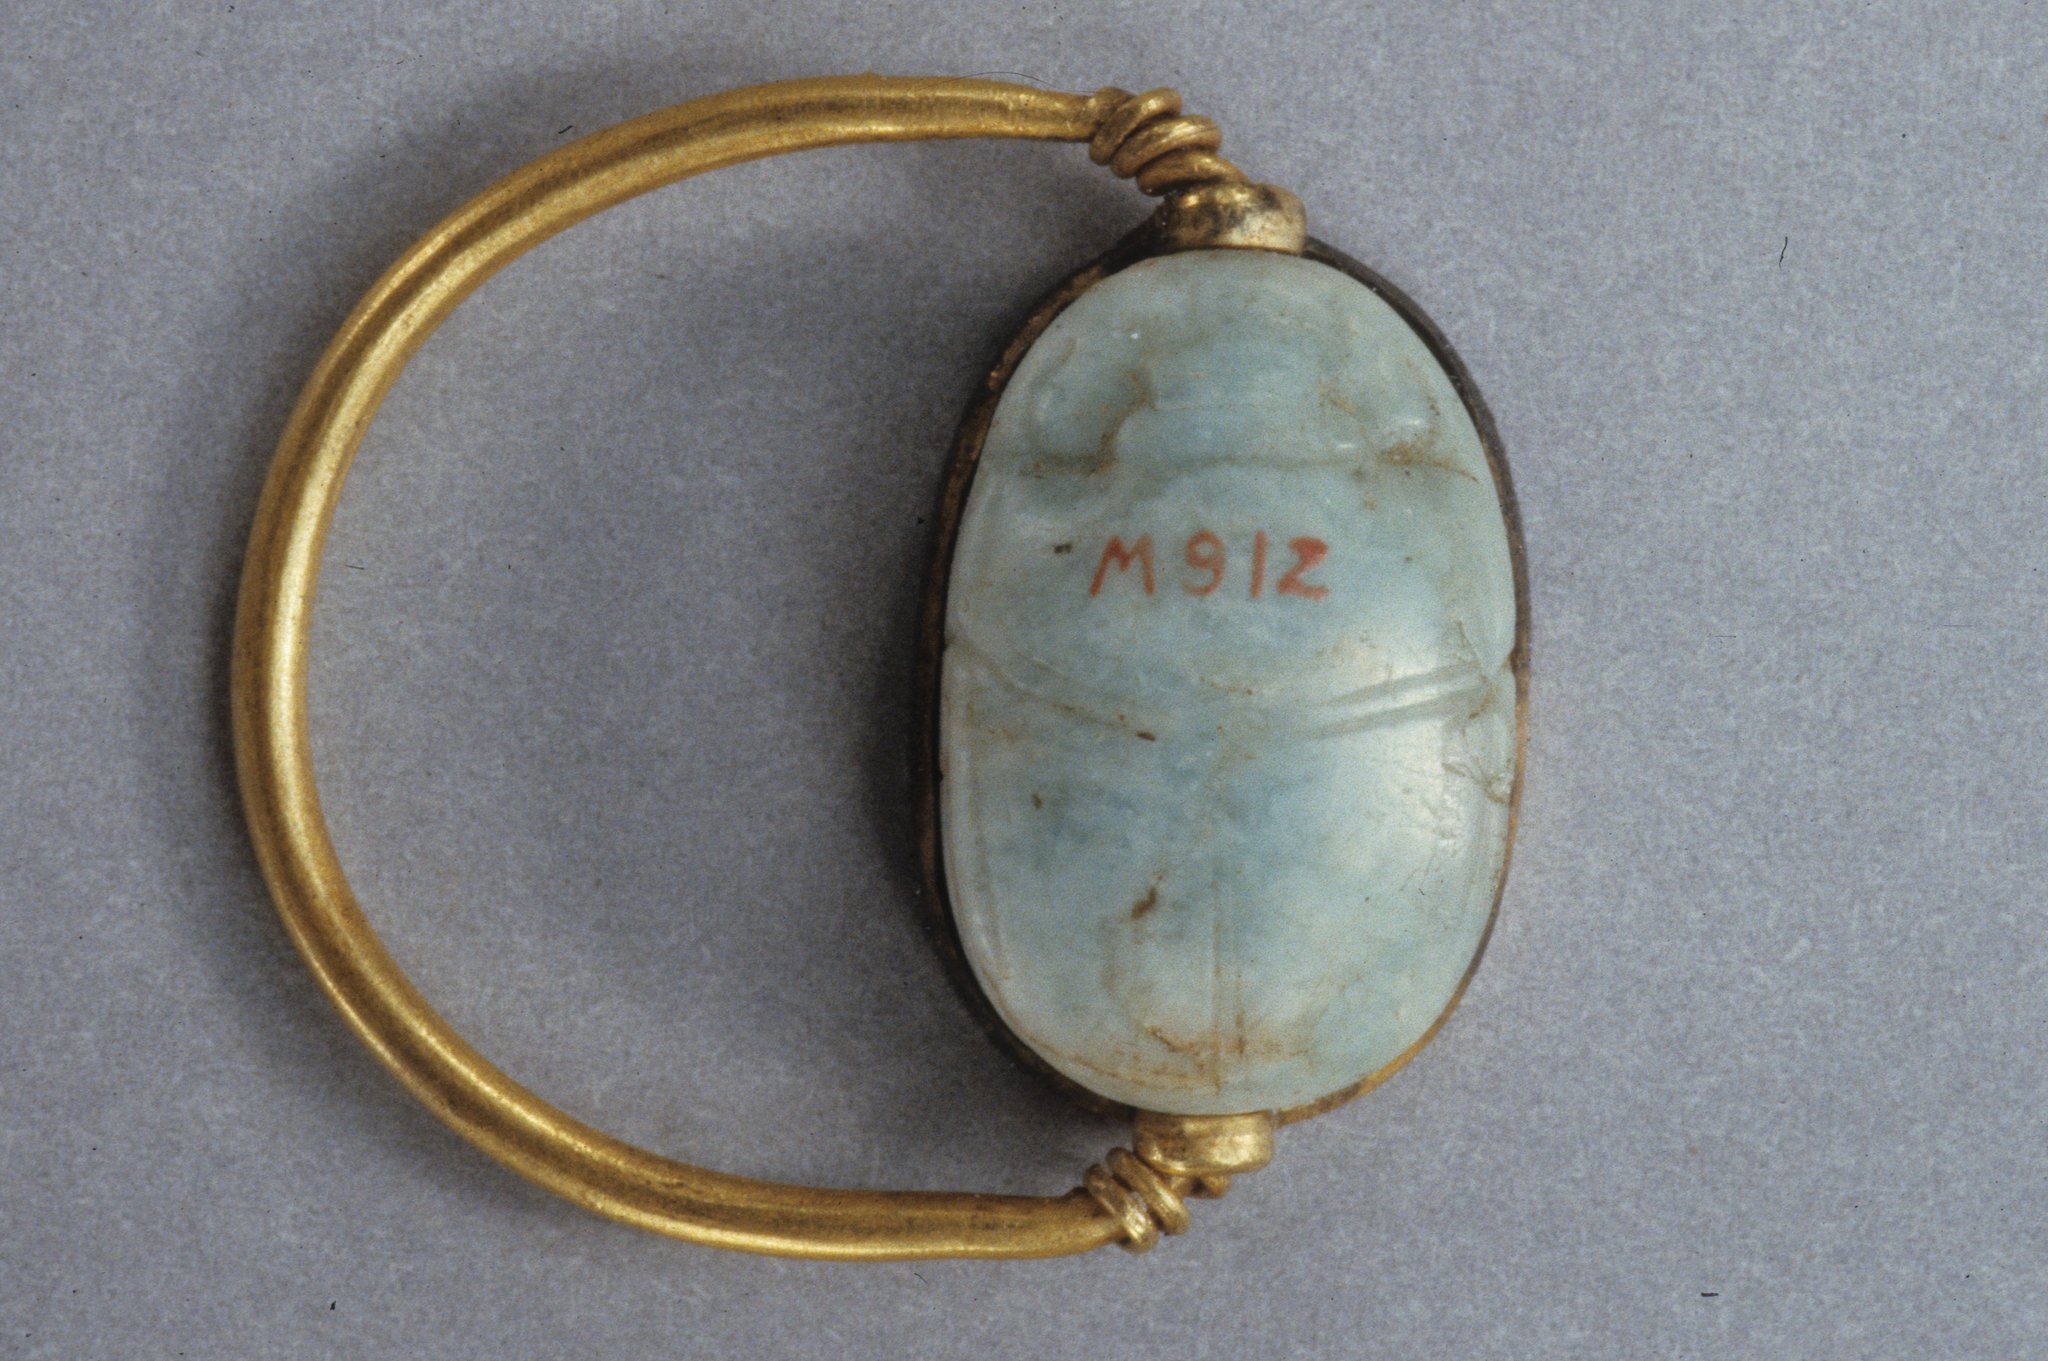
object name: ring, scarab, overseer im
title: Scarab Ring of the Storeroom Overseer Im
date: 1802-1640 BCE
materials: gold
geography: egypt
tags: hieroglyphs,scarabs